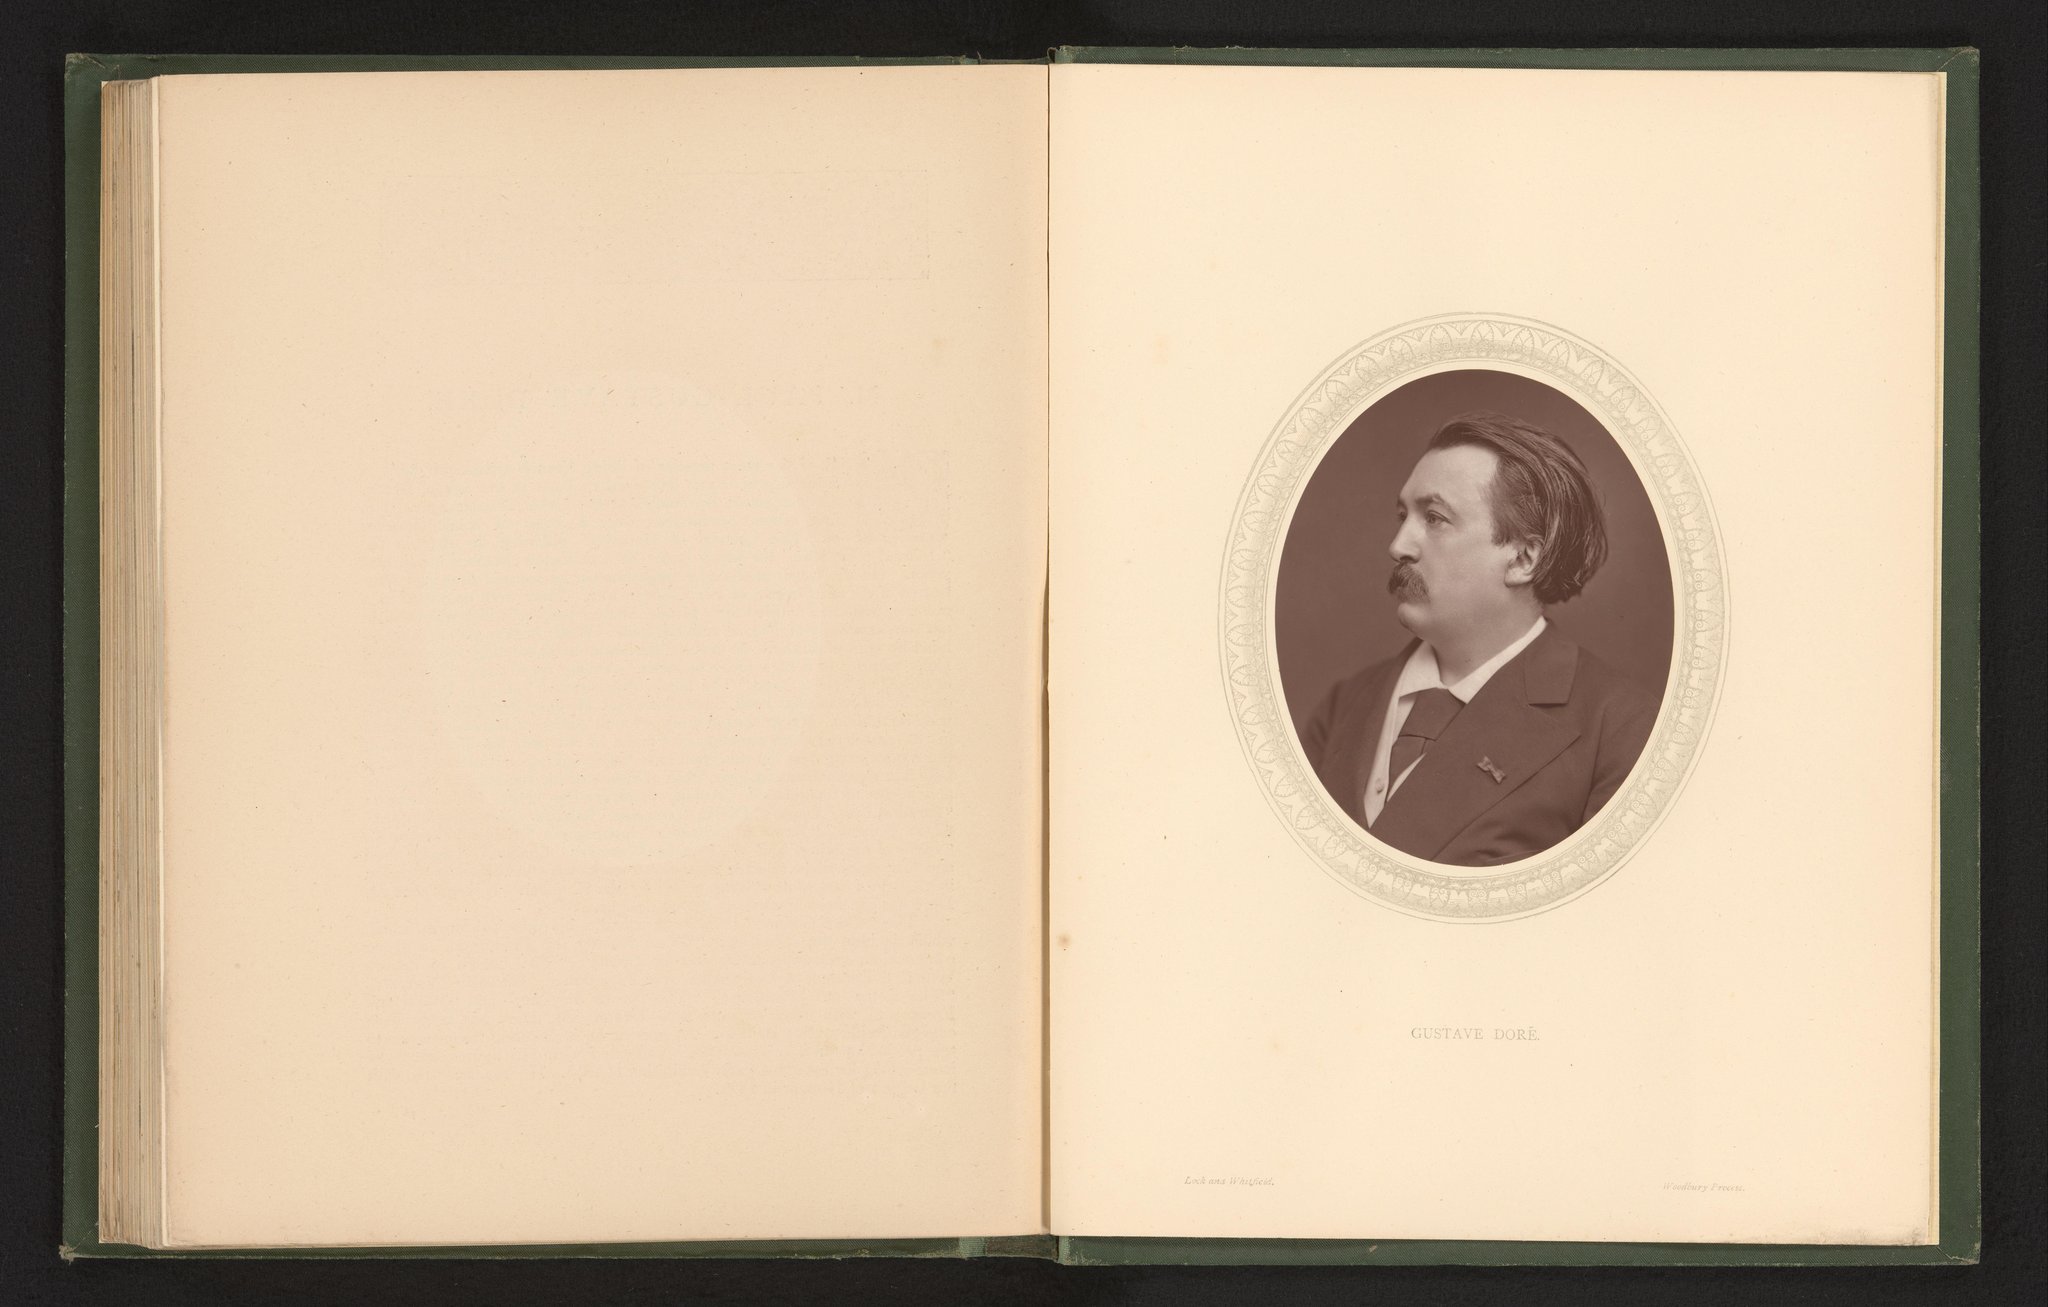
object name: photomechanical print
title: Gustave Doré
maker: Anonymous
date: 1872-1877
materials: paper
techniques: woodburytype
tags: paris, print maker, draughtsman, gustave doré, historical persons (portraits and scenes from the life) (+ (full) bust portrait), graphic artist